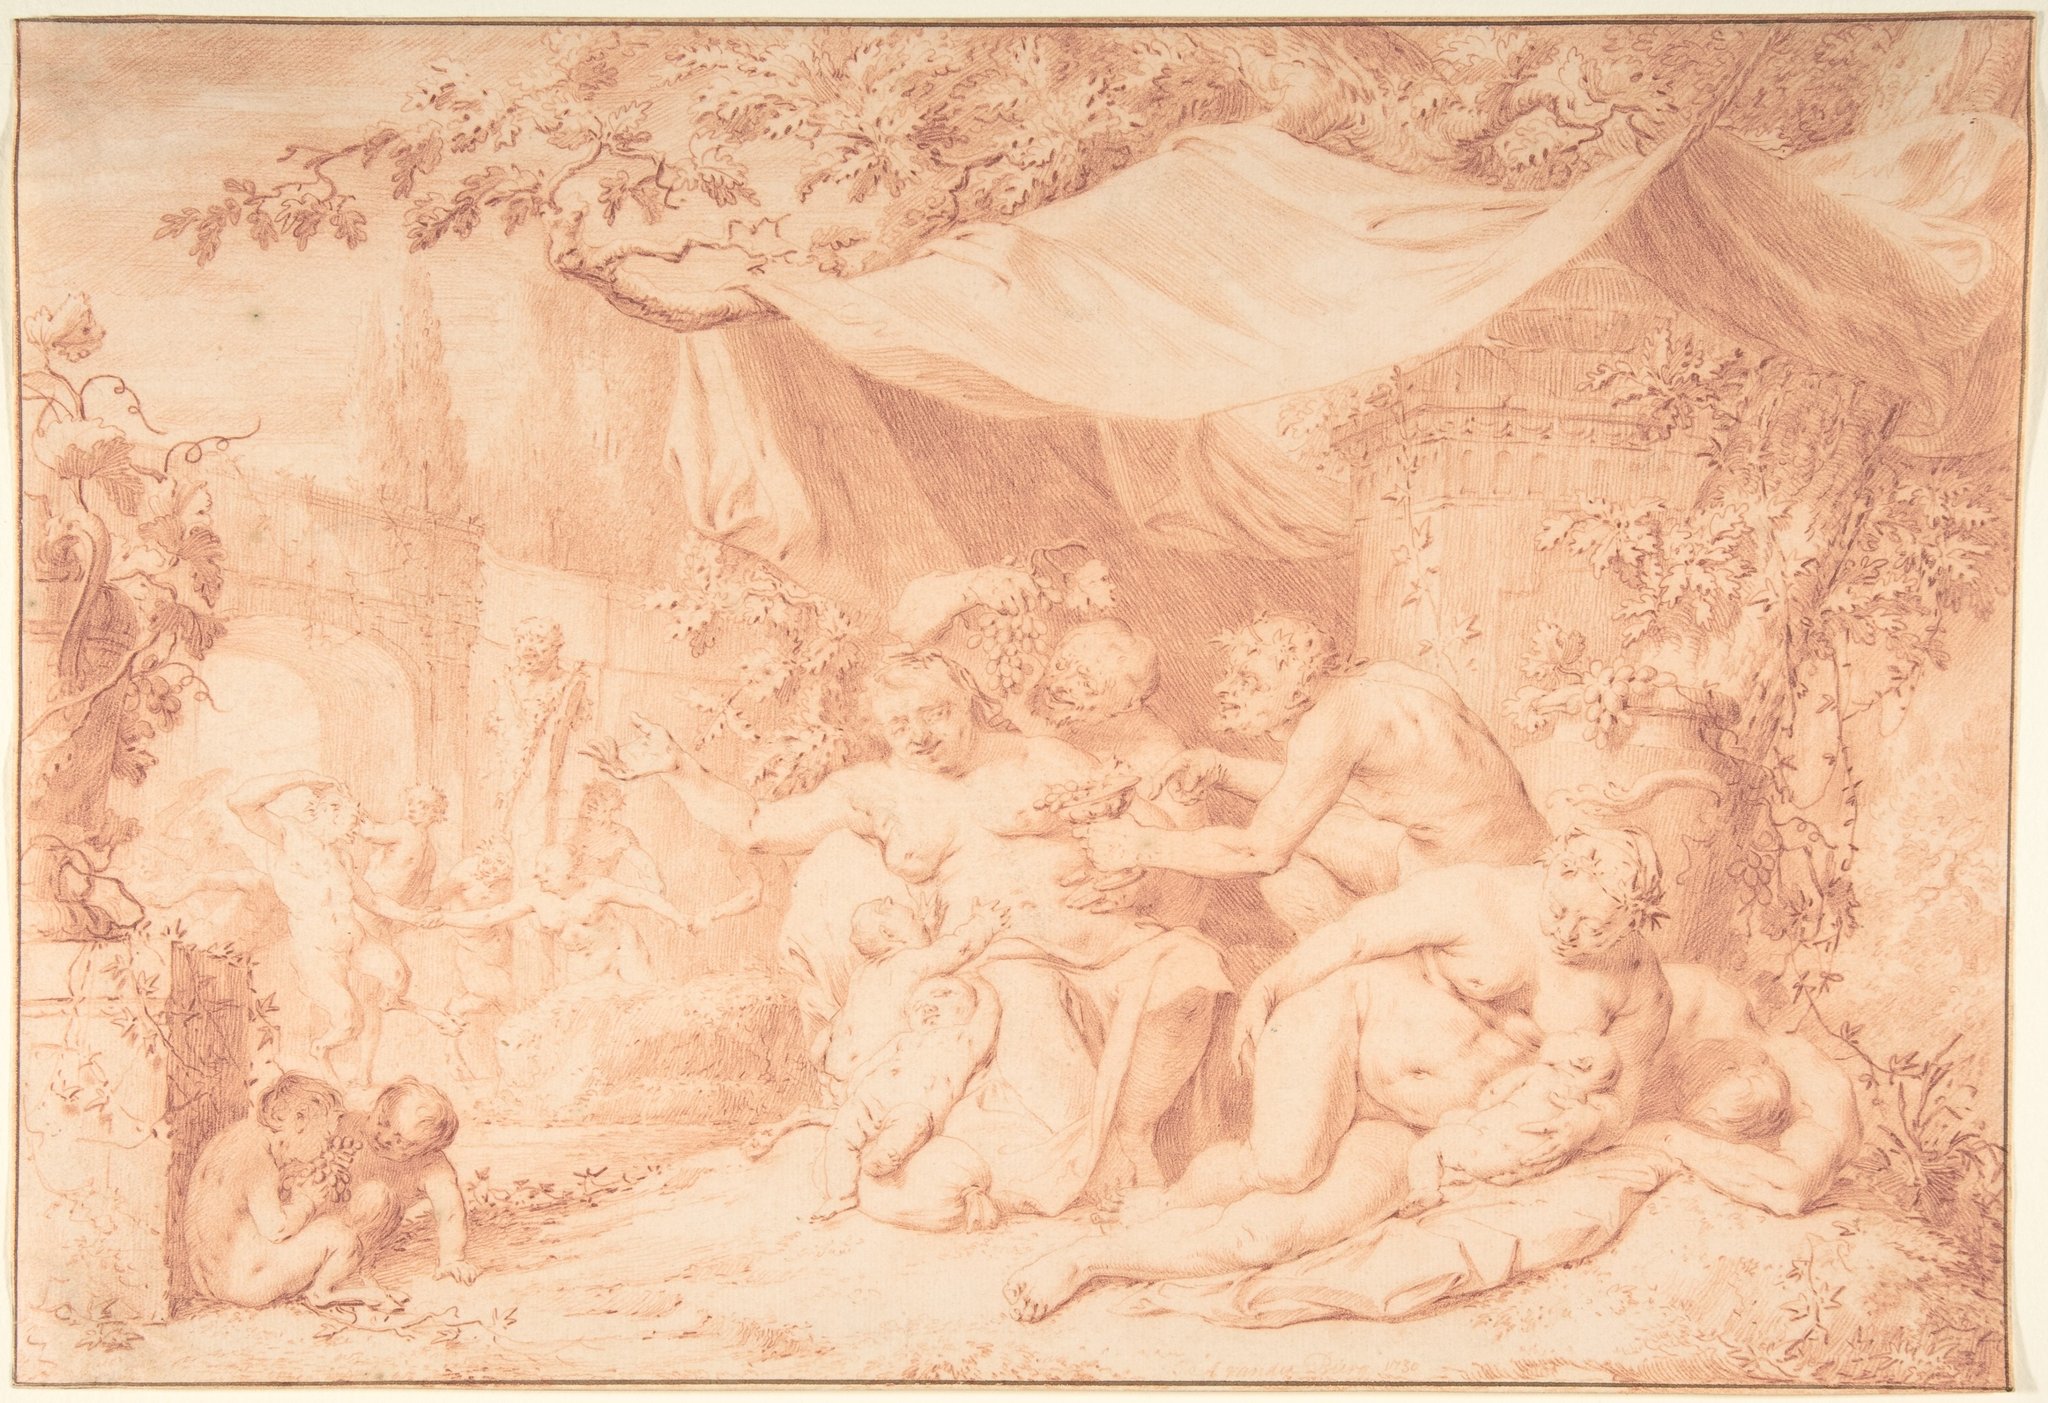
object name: drawing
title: Bacchanal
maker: adriaan van der burg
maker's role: artist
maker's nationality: dutch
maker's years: 1693-1733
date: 1701-1733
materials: chalk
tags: children,female nudes,satyrs